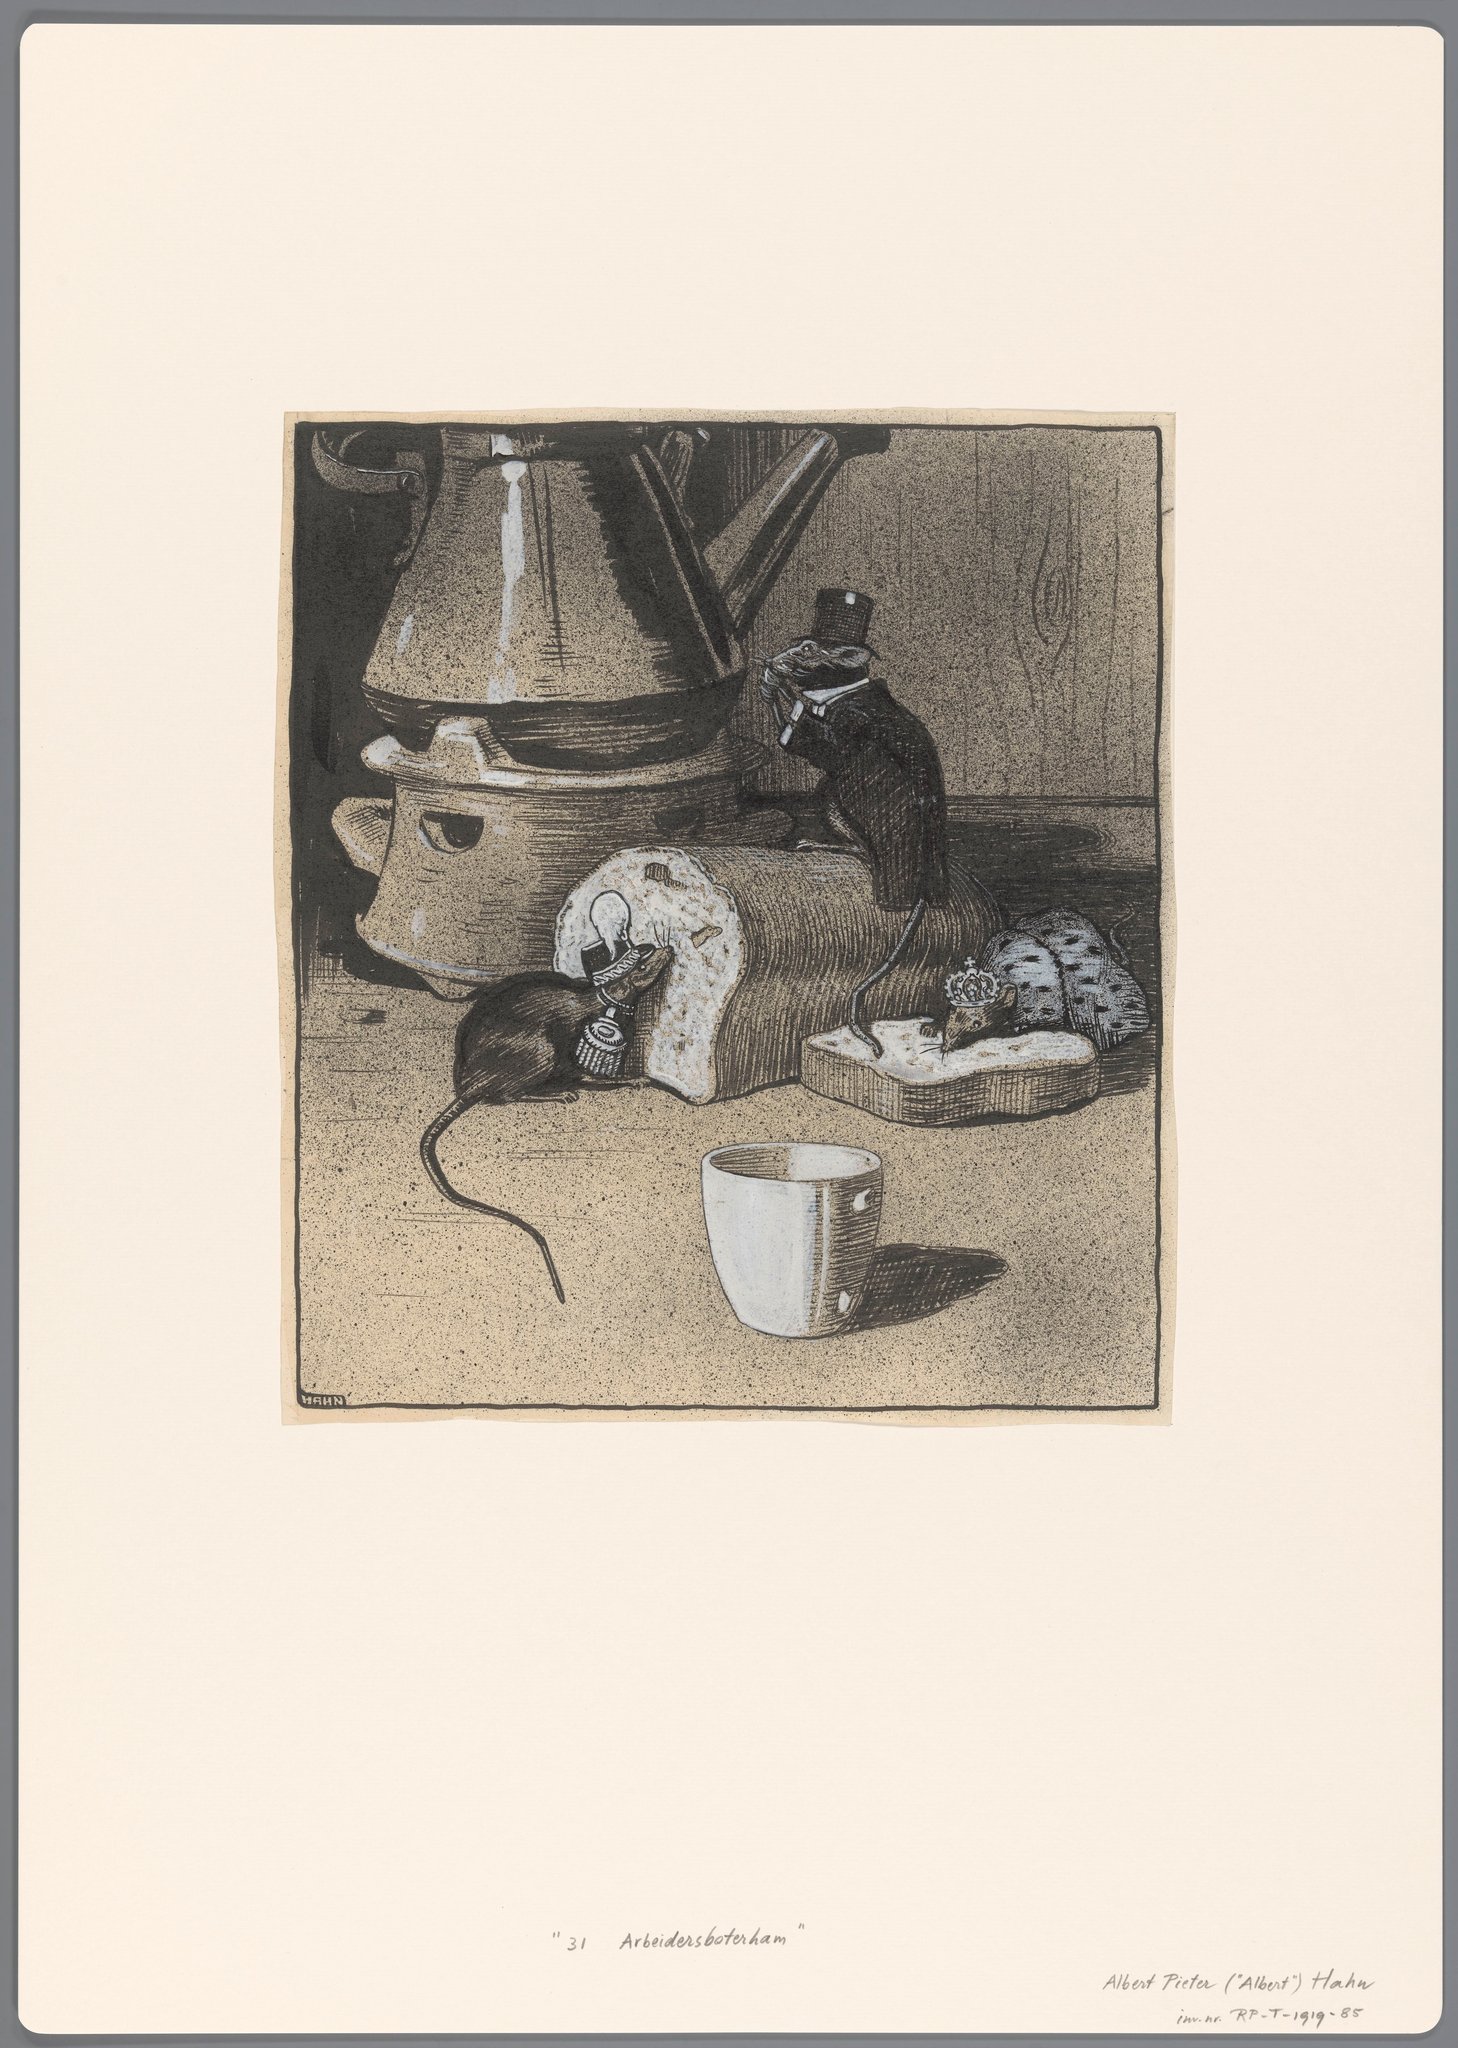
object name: design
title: Ontwerp voor een politieke spotprent: De Gulzige knaagdieren. Aan de arbeiders-boterham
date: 1887-1919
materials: paint, ink, paper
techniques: brush, pen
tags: war of classes, rodents: rat, political caricatures and satires